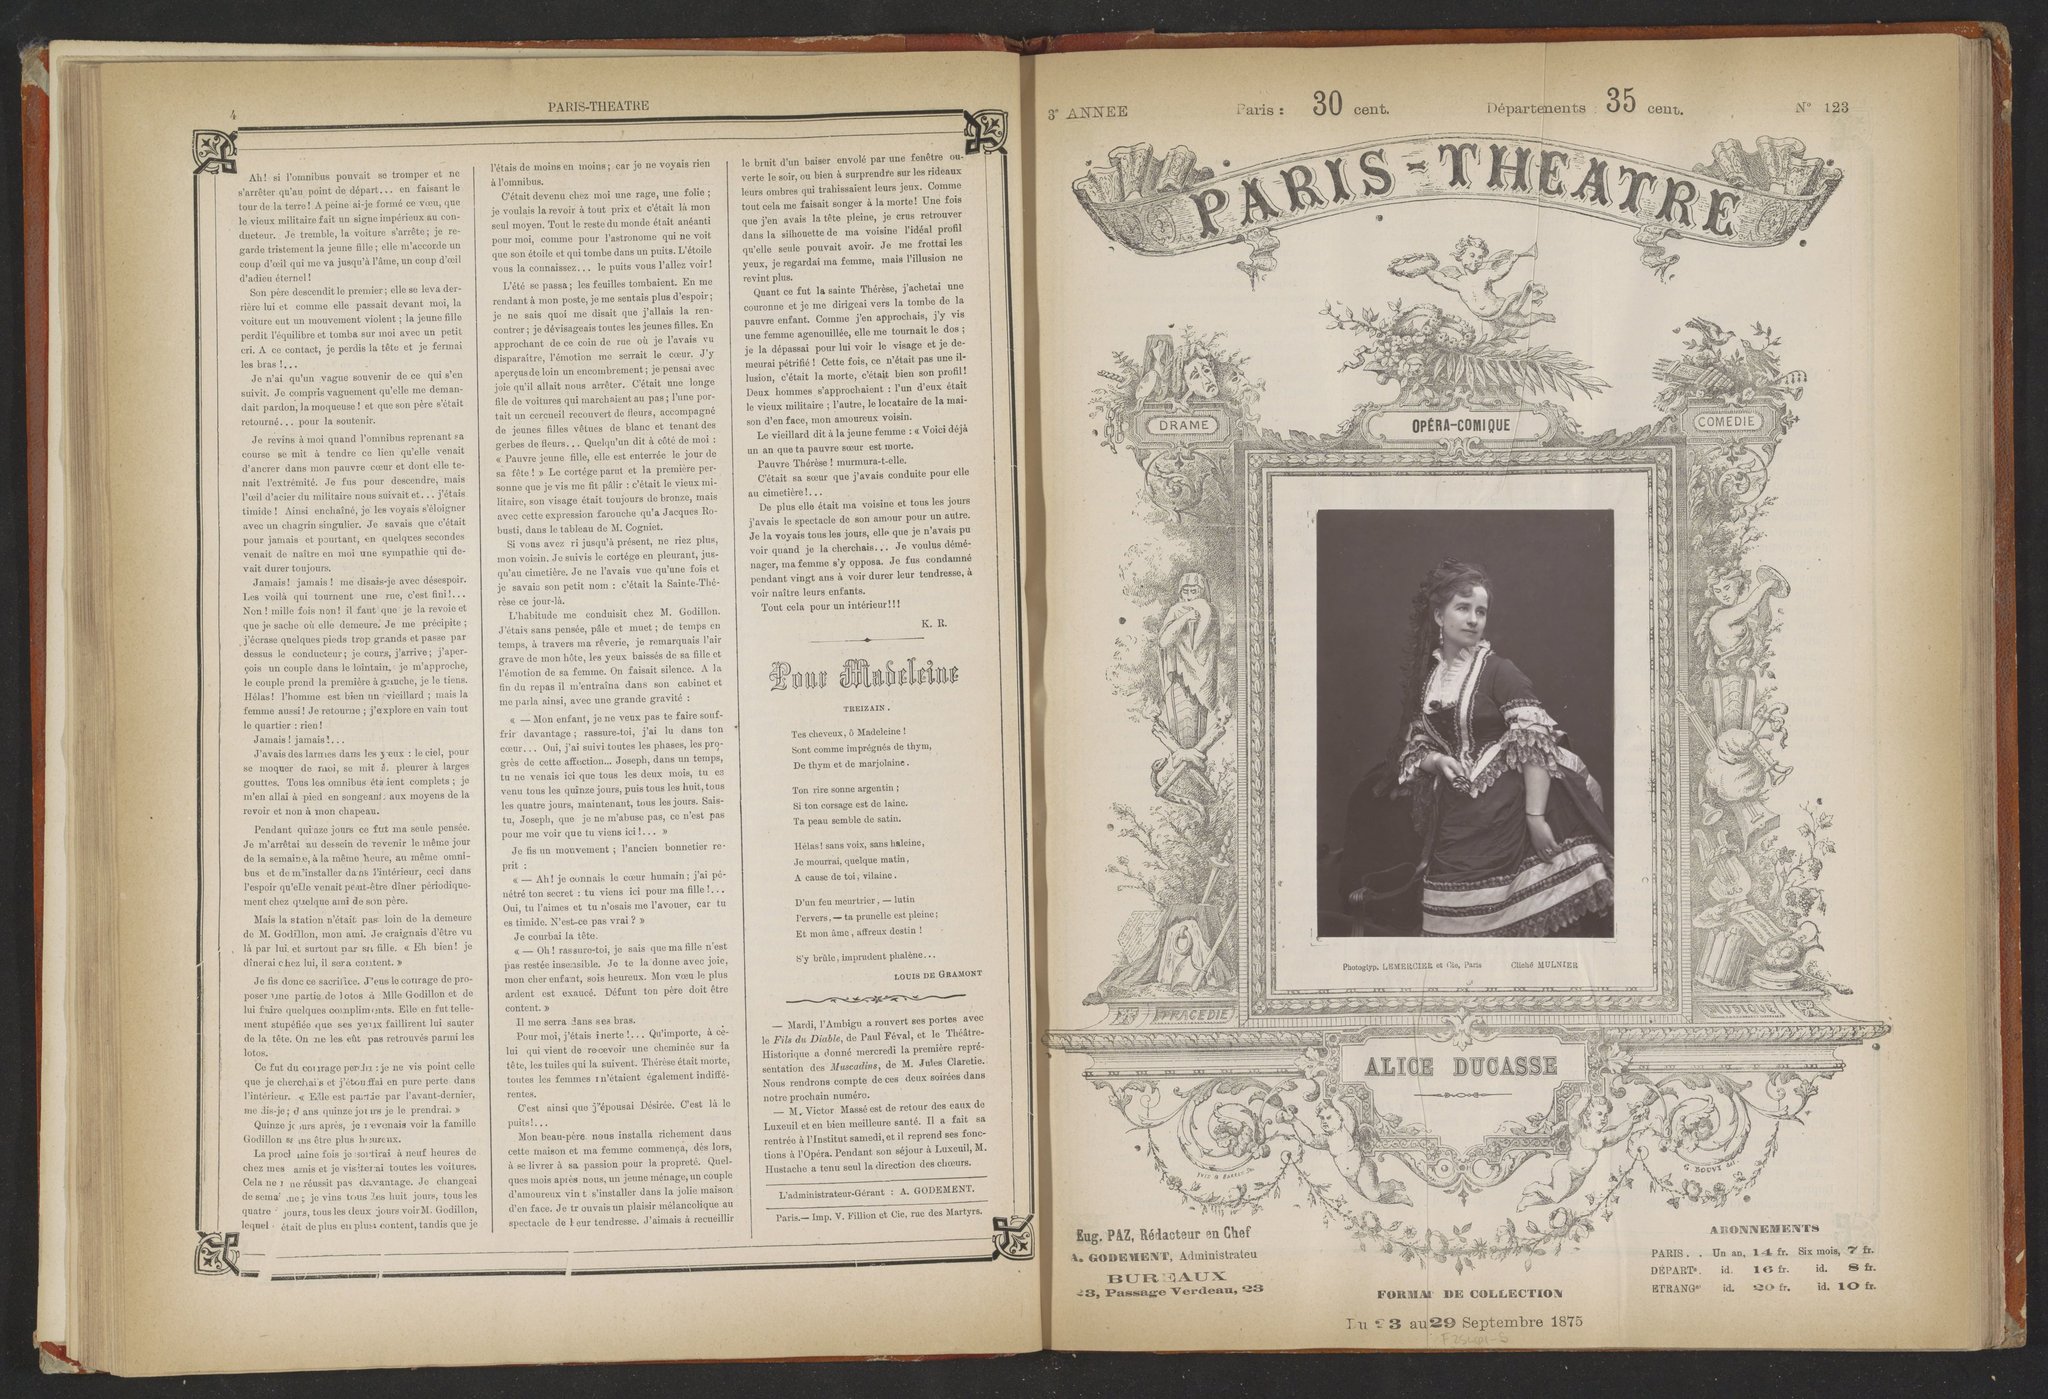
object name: photomechanical print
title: Portret van Alice Ducasse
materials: paper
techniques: woodburytype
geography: france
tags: portrait of opera-singer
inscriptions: inscription: ‘Du 23 au 29 Septembre 1875’, number: ‘No 123’